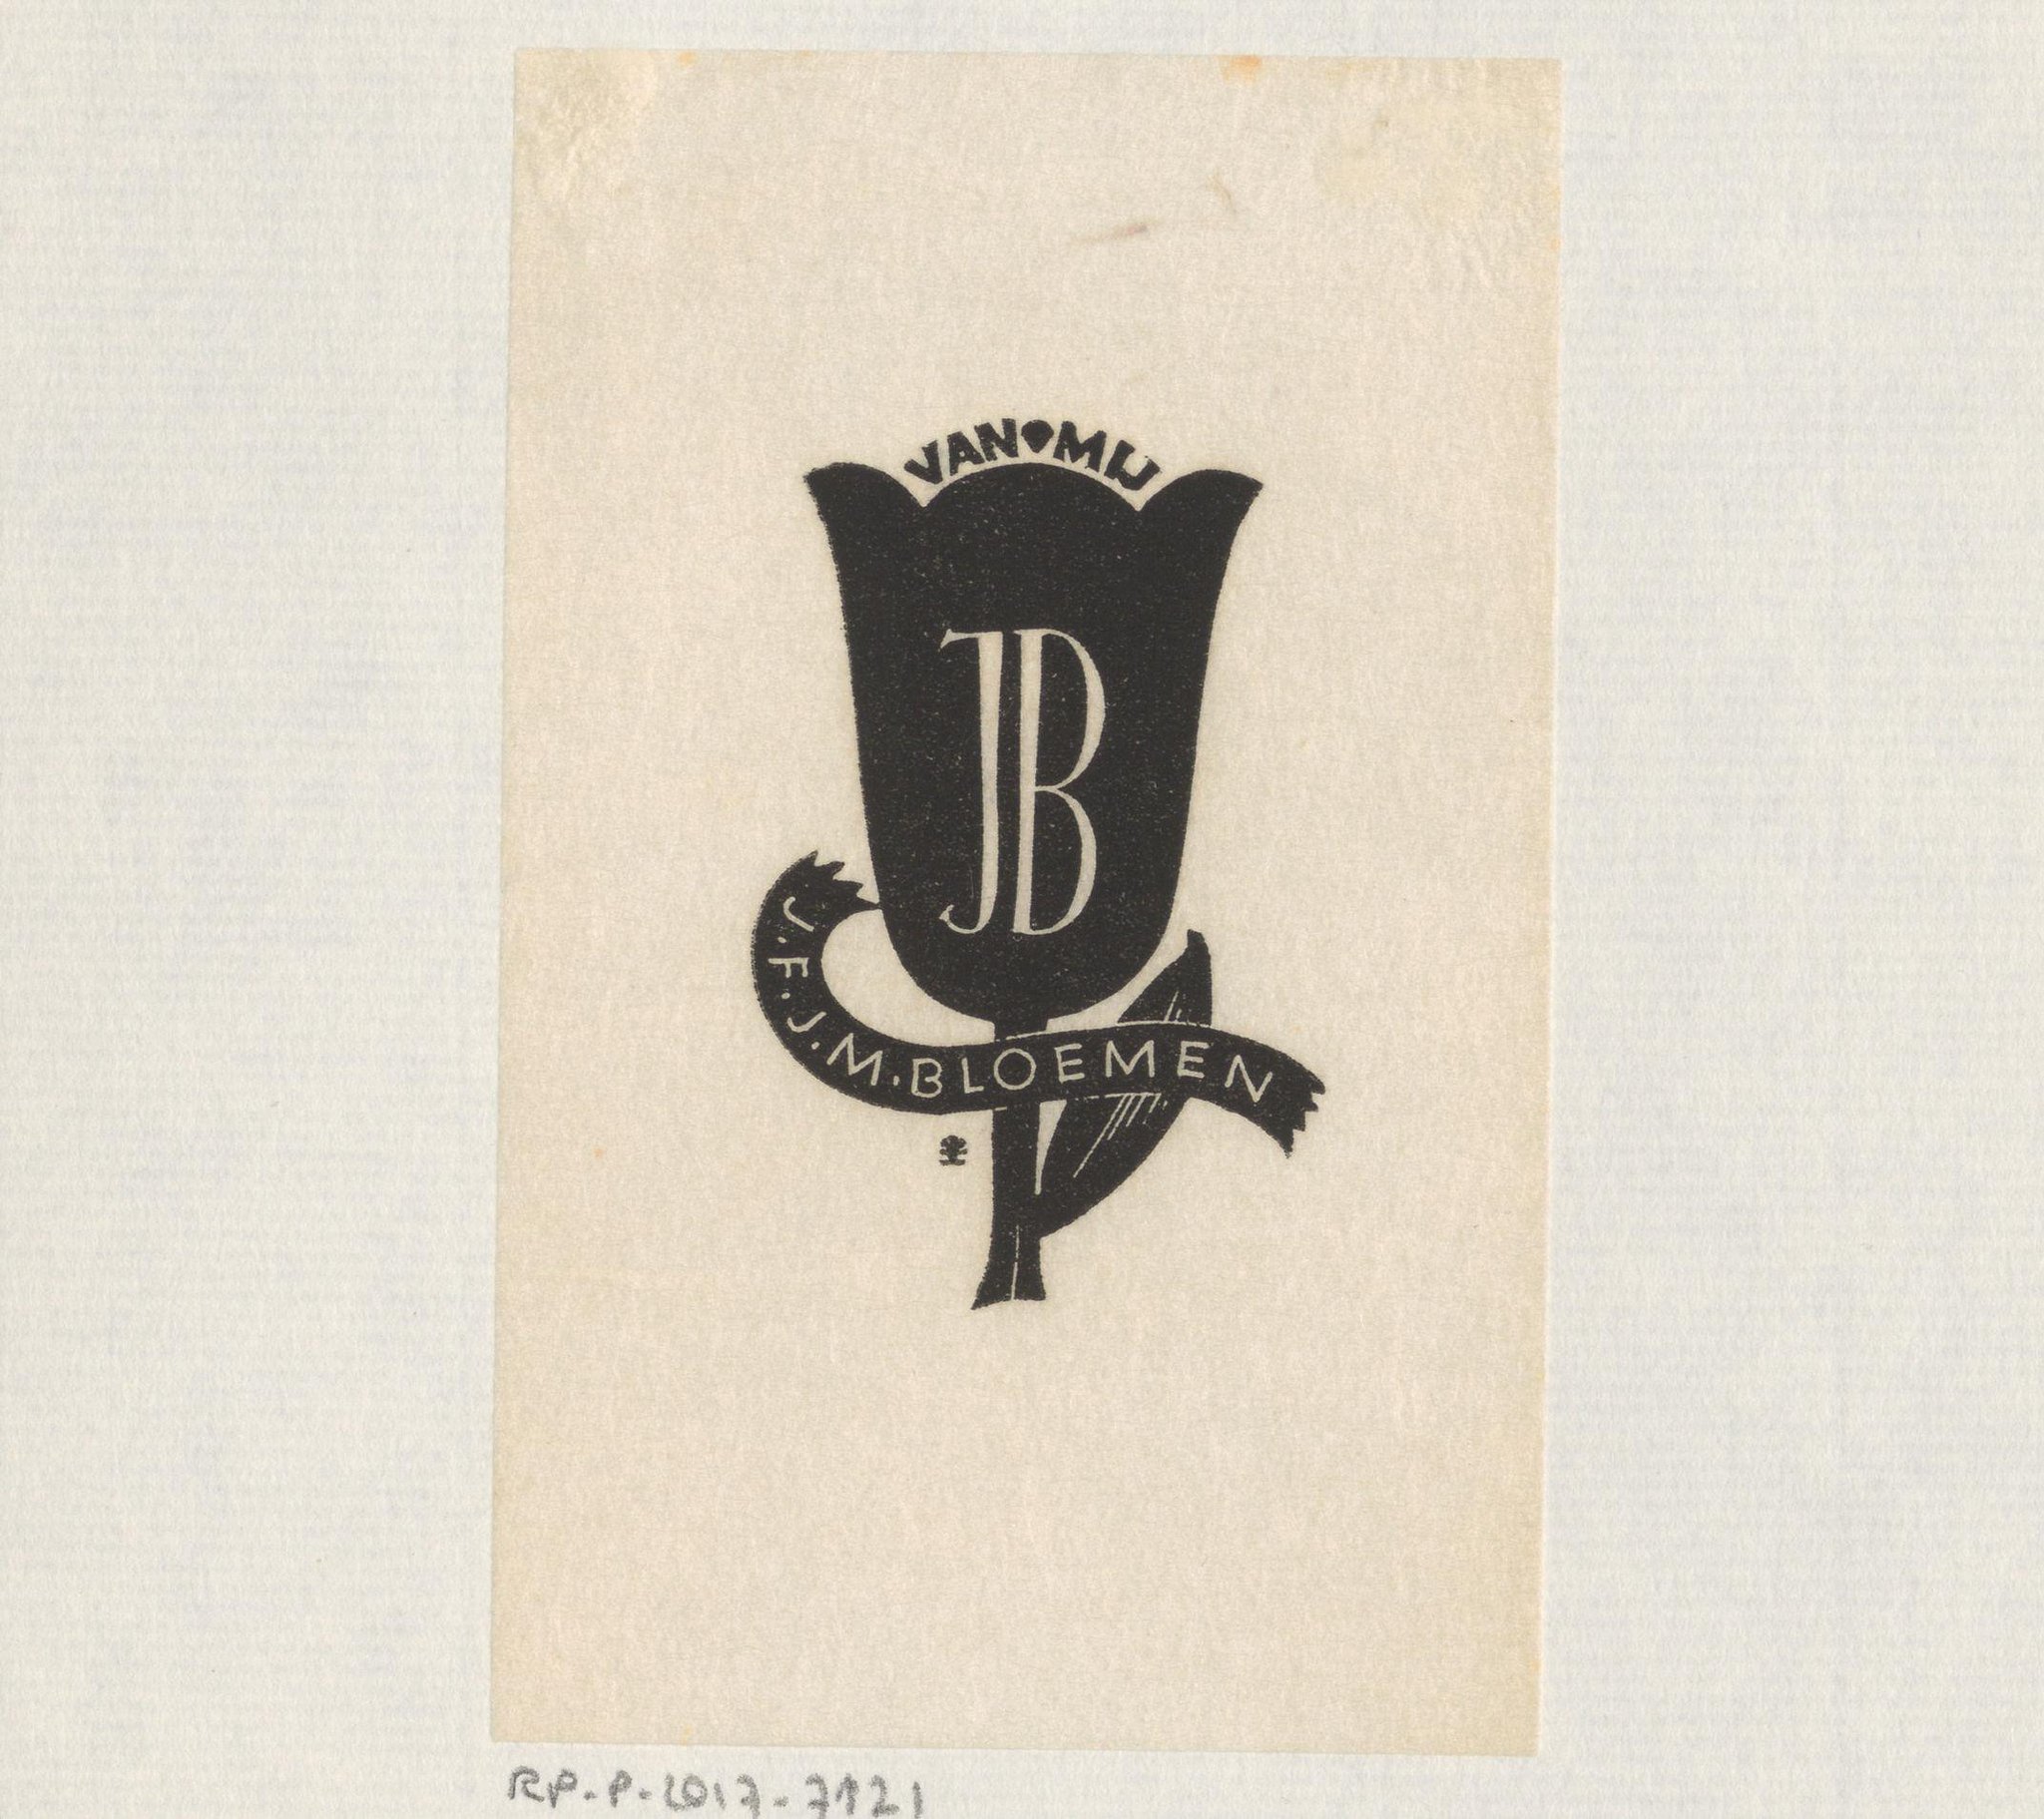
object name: bookplate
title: Ex libris van J.F.J.M. Bloemen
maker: karl haselböck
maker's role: print maker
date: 1900-1949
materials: paper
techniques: woodcut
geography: vienna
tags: flowers: tulip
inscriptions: workshop stamp: ‘Karl Haselböck/ Wiener Neustadt/ Houtsnede’